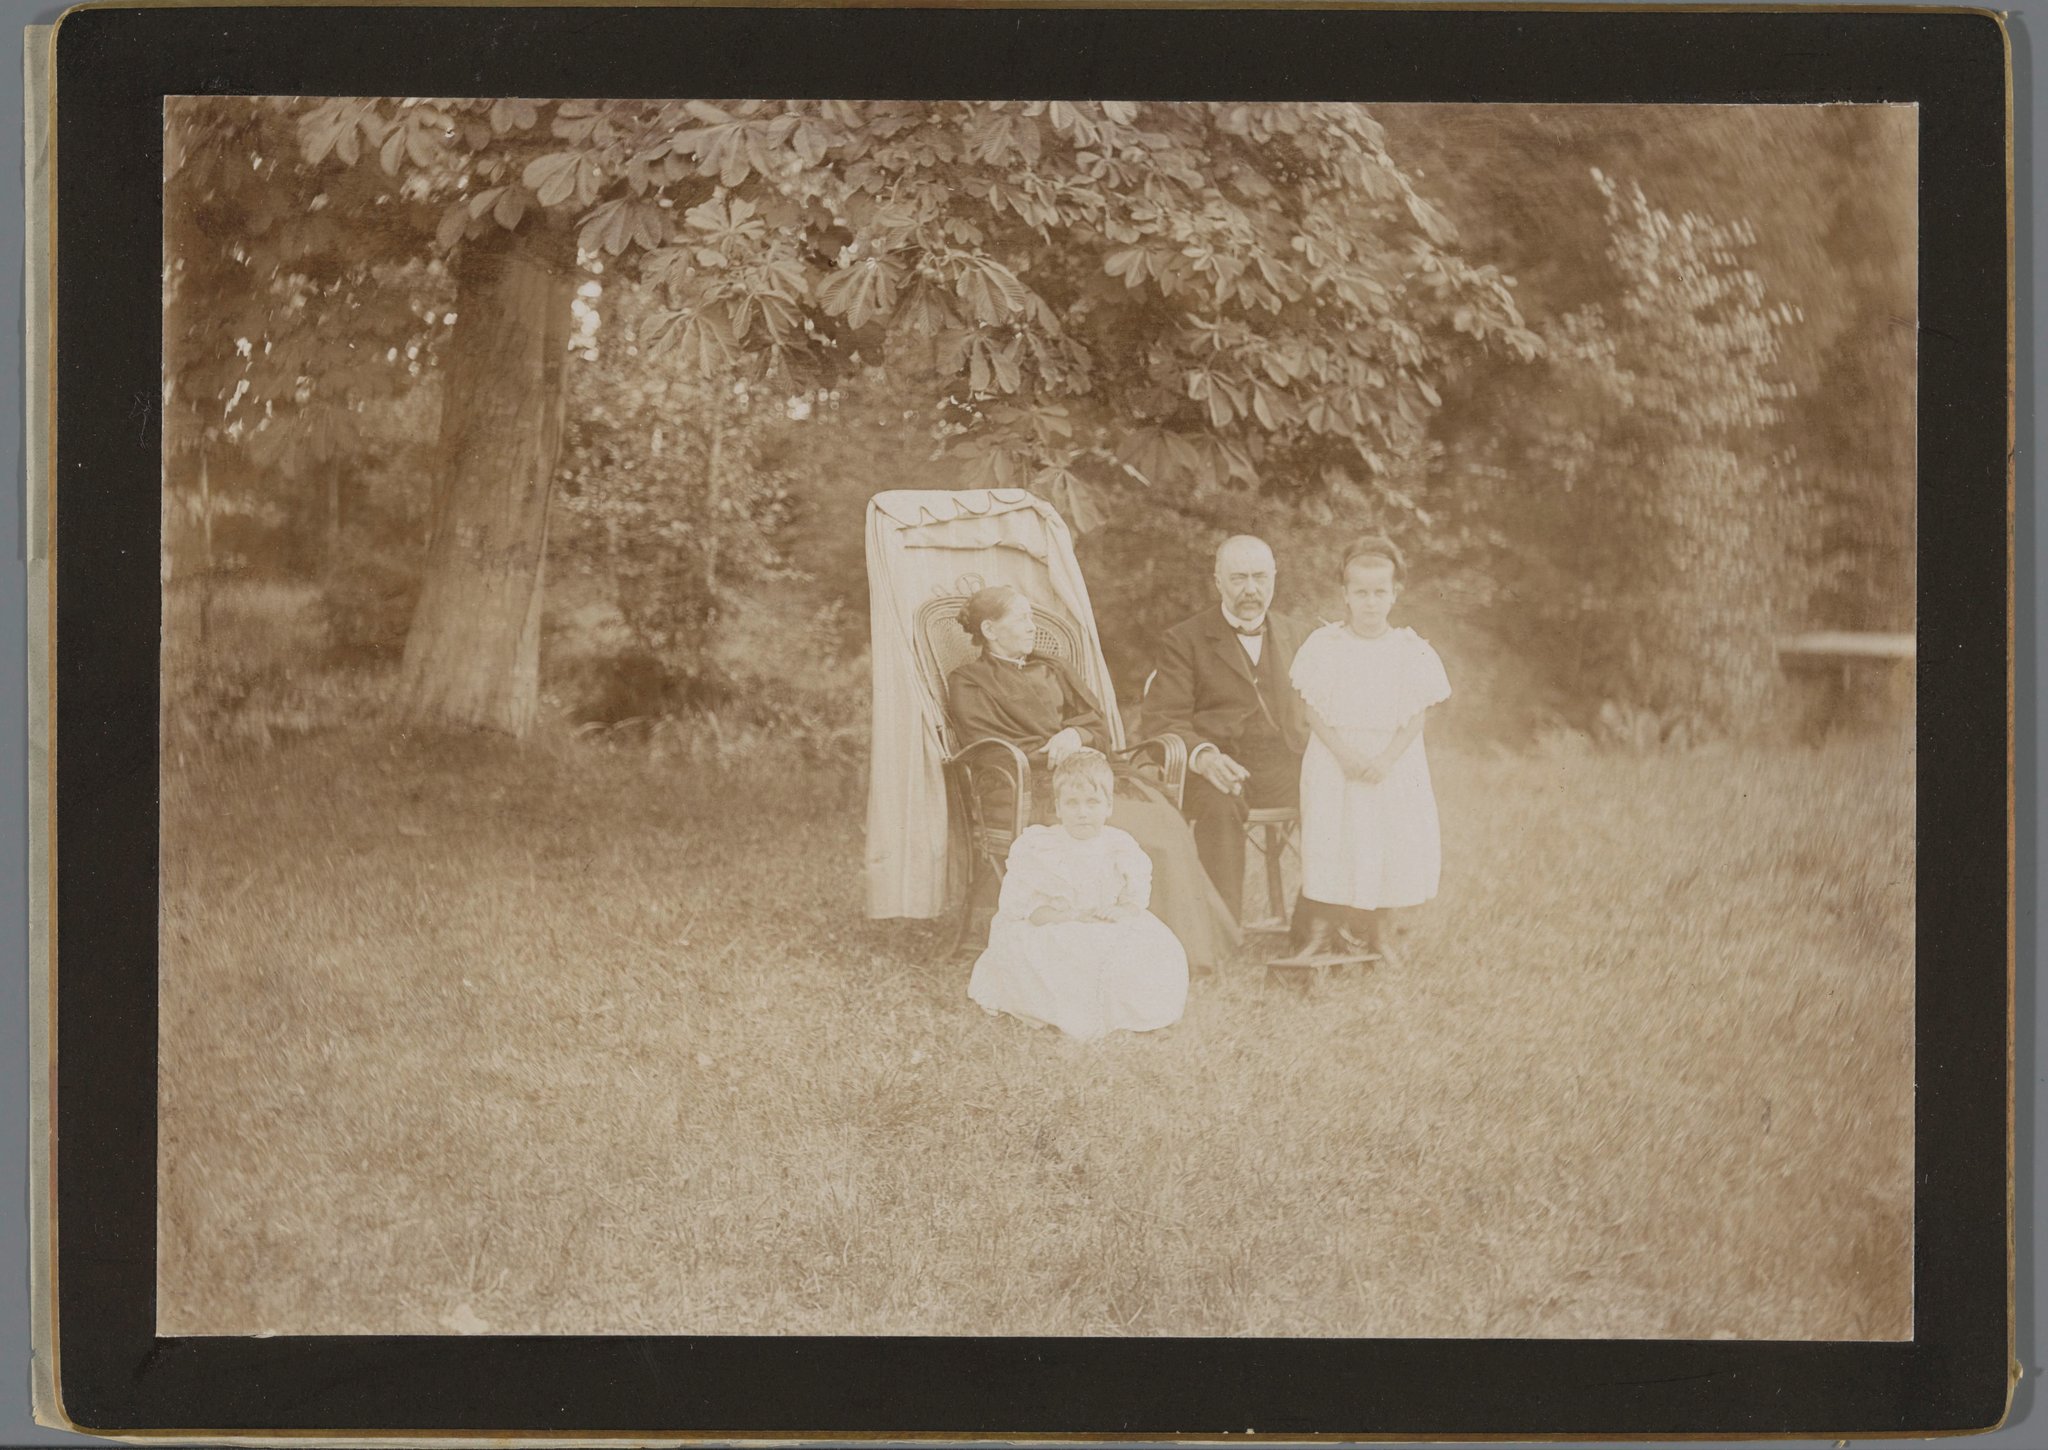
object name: photograph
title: Groepsportret van Lucas Jonker, Johanna Geertruida Jonker Nije en twee kinderen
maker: cornelia hendrika jonker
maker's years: 1874-1924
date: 1896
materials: cardboard, photographic support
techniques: collodion silver print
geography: maartensdijk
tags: garden, anonymous historical persons portrayed in a group, in a group-portrait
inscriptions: annotation: ‘C.J. september '96’